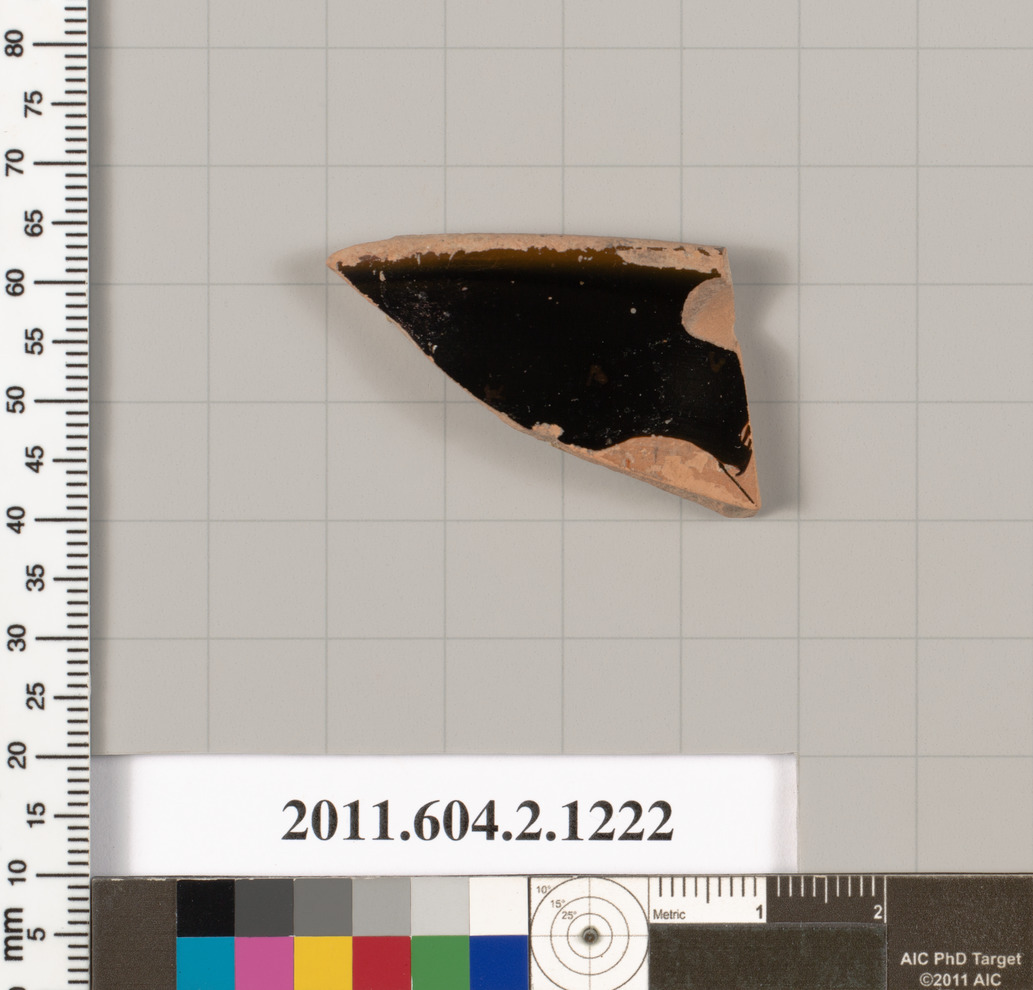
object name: kantharos fragment, head vase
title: Terracotta fragment from a kantharos: head vase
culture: greek, attic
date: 490-470 BCE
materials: terracotta